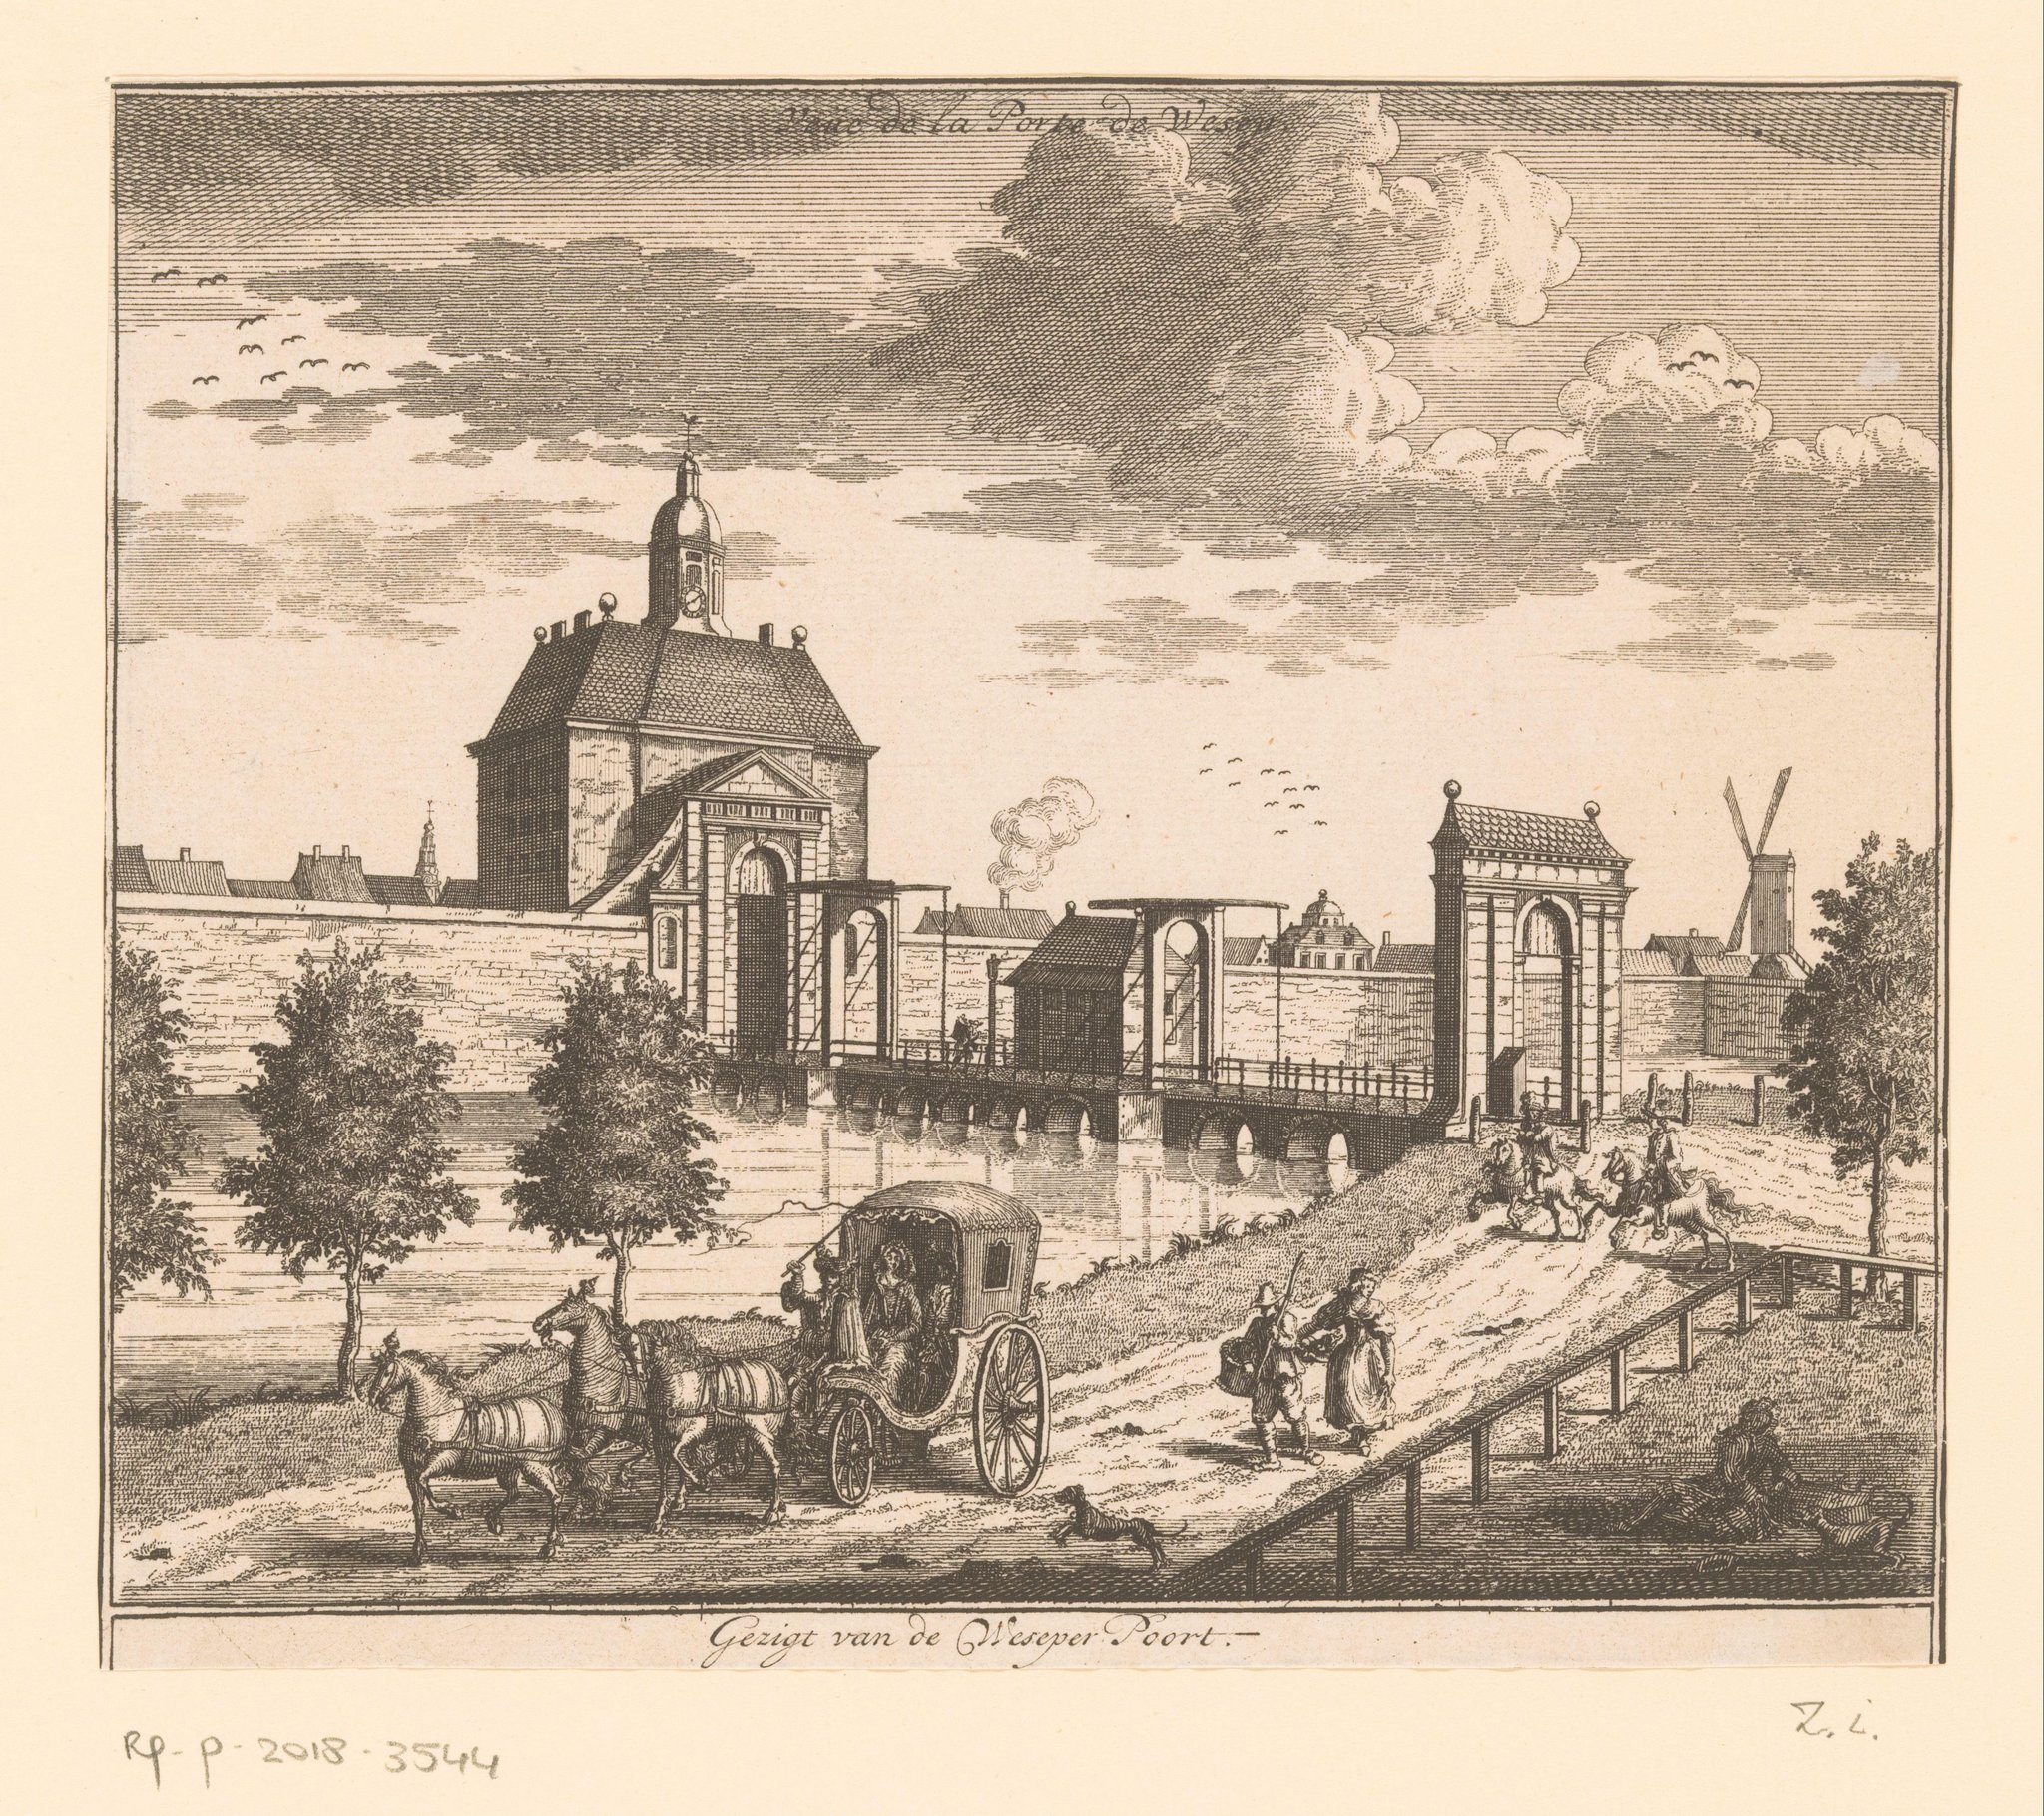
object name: print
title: Gezigt van de Weesper Poort / Veüe de la Porte de Weesp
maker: Anonymous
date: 1700-1799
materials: paper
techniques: engraving, etching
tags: four-wheeled vehicle drawn by three animals, bridge in city across river, canal, etc., city-gate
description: Deze prent lijkt sterk op de uitgave van Pieter Schenk, RP-P-1911-3449.